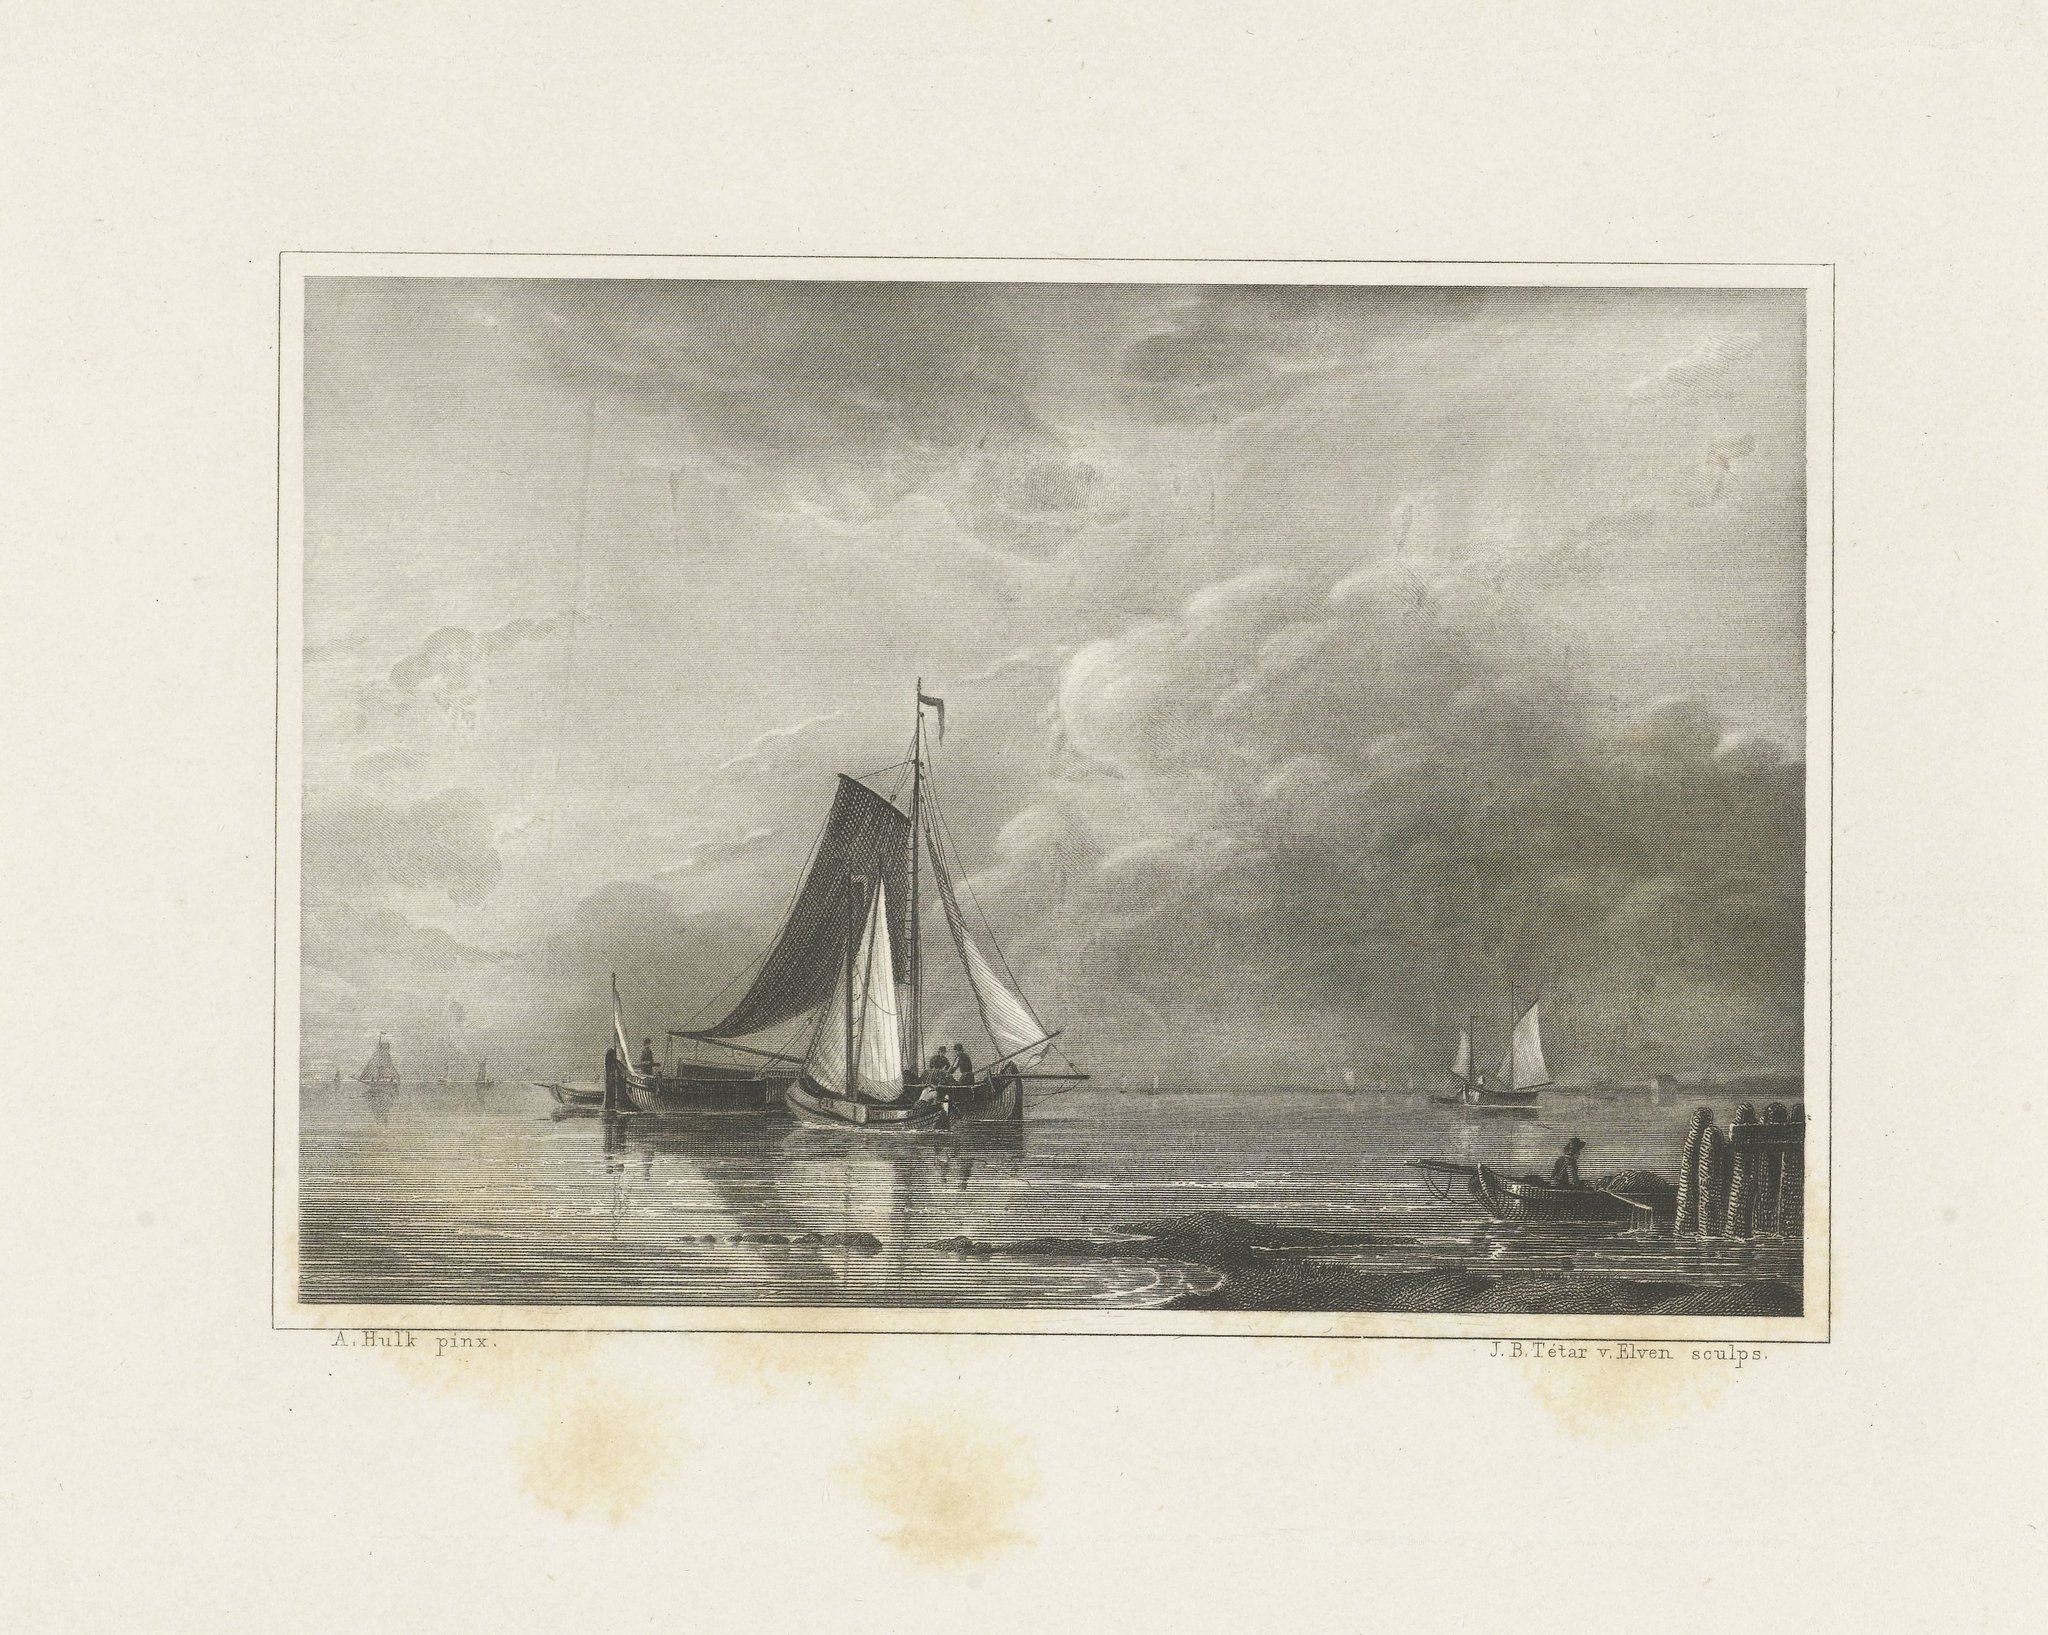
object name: print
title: Zeilschepen op het water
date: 1815-1889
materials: paper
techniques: engraving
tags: sailing-ship, sailing-boat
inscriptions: collector's mark: Lugt 2228, collector's mark: Lugt 2760